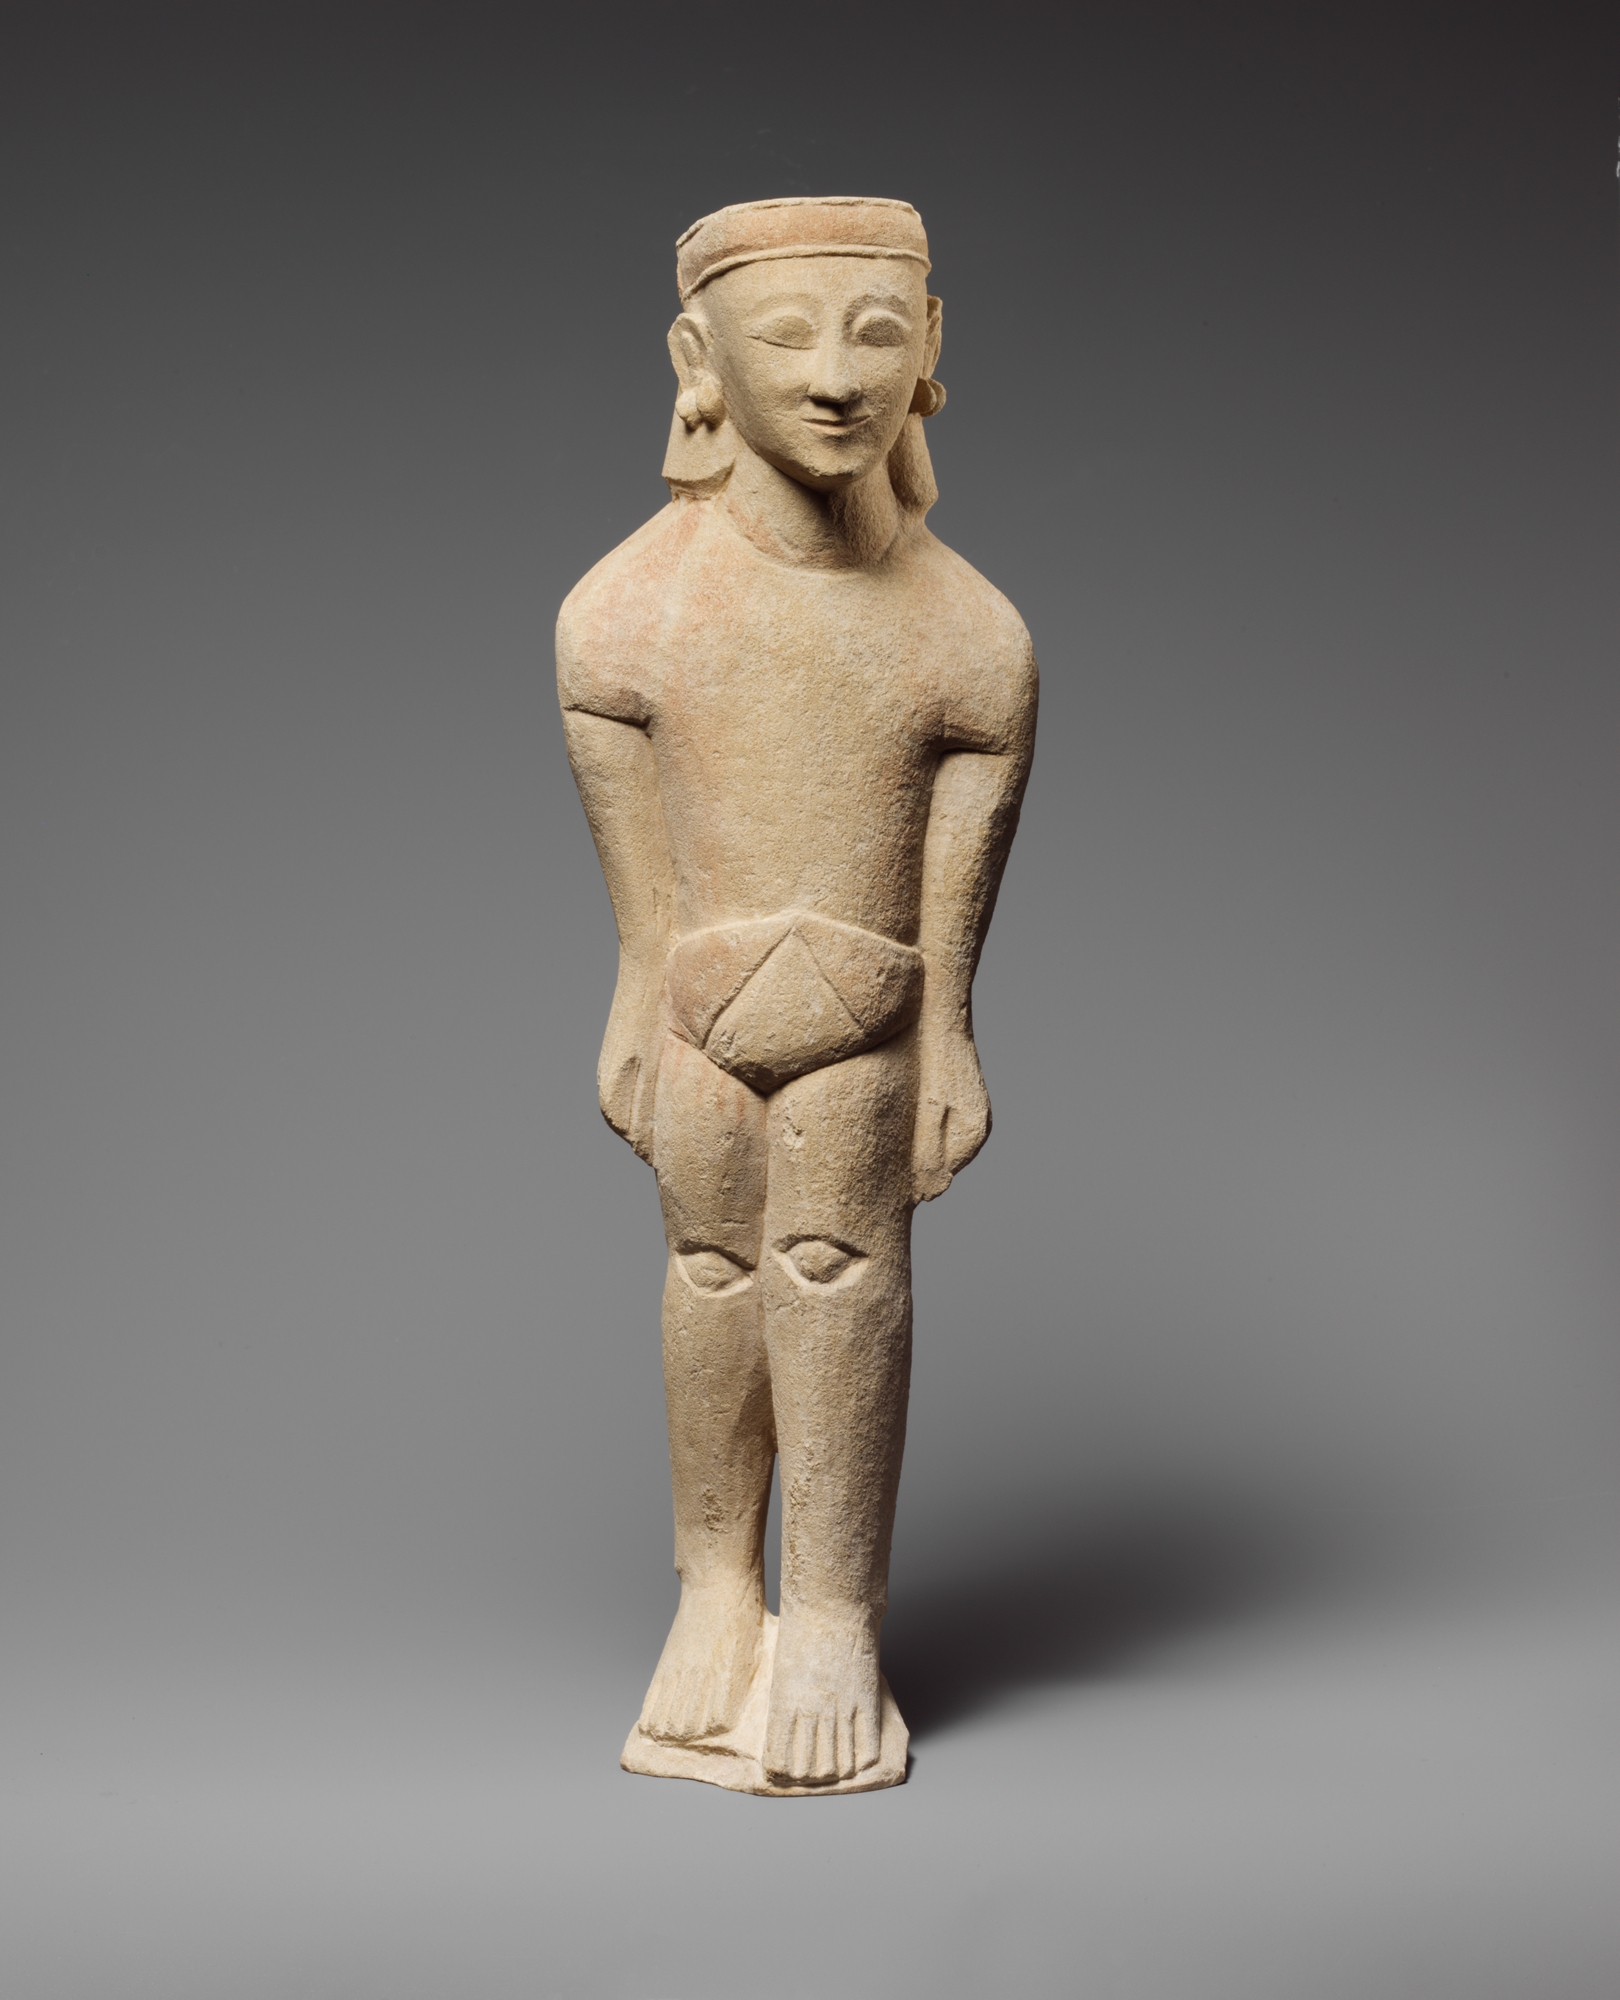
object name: statuette of a votary, male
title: Limestone statuette of a male votary with Cypriot shorts and a diadem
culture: cypriot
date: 600-568 BCE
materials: limestone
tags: diadems,men